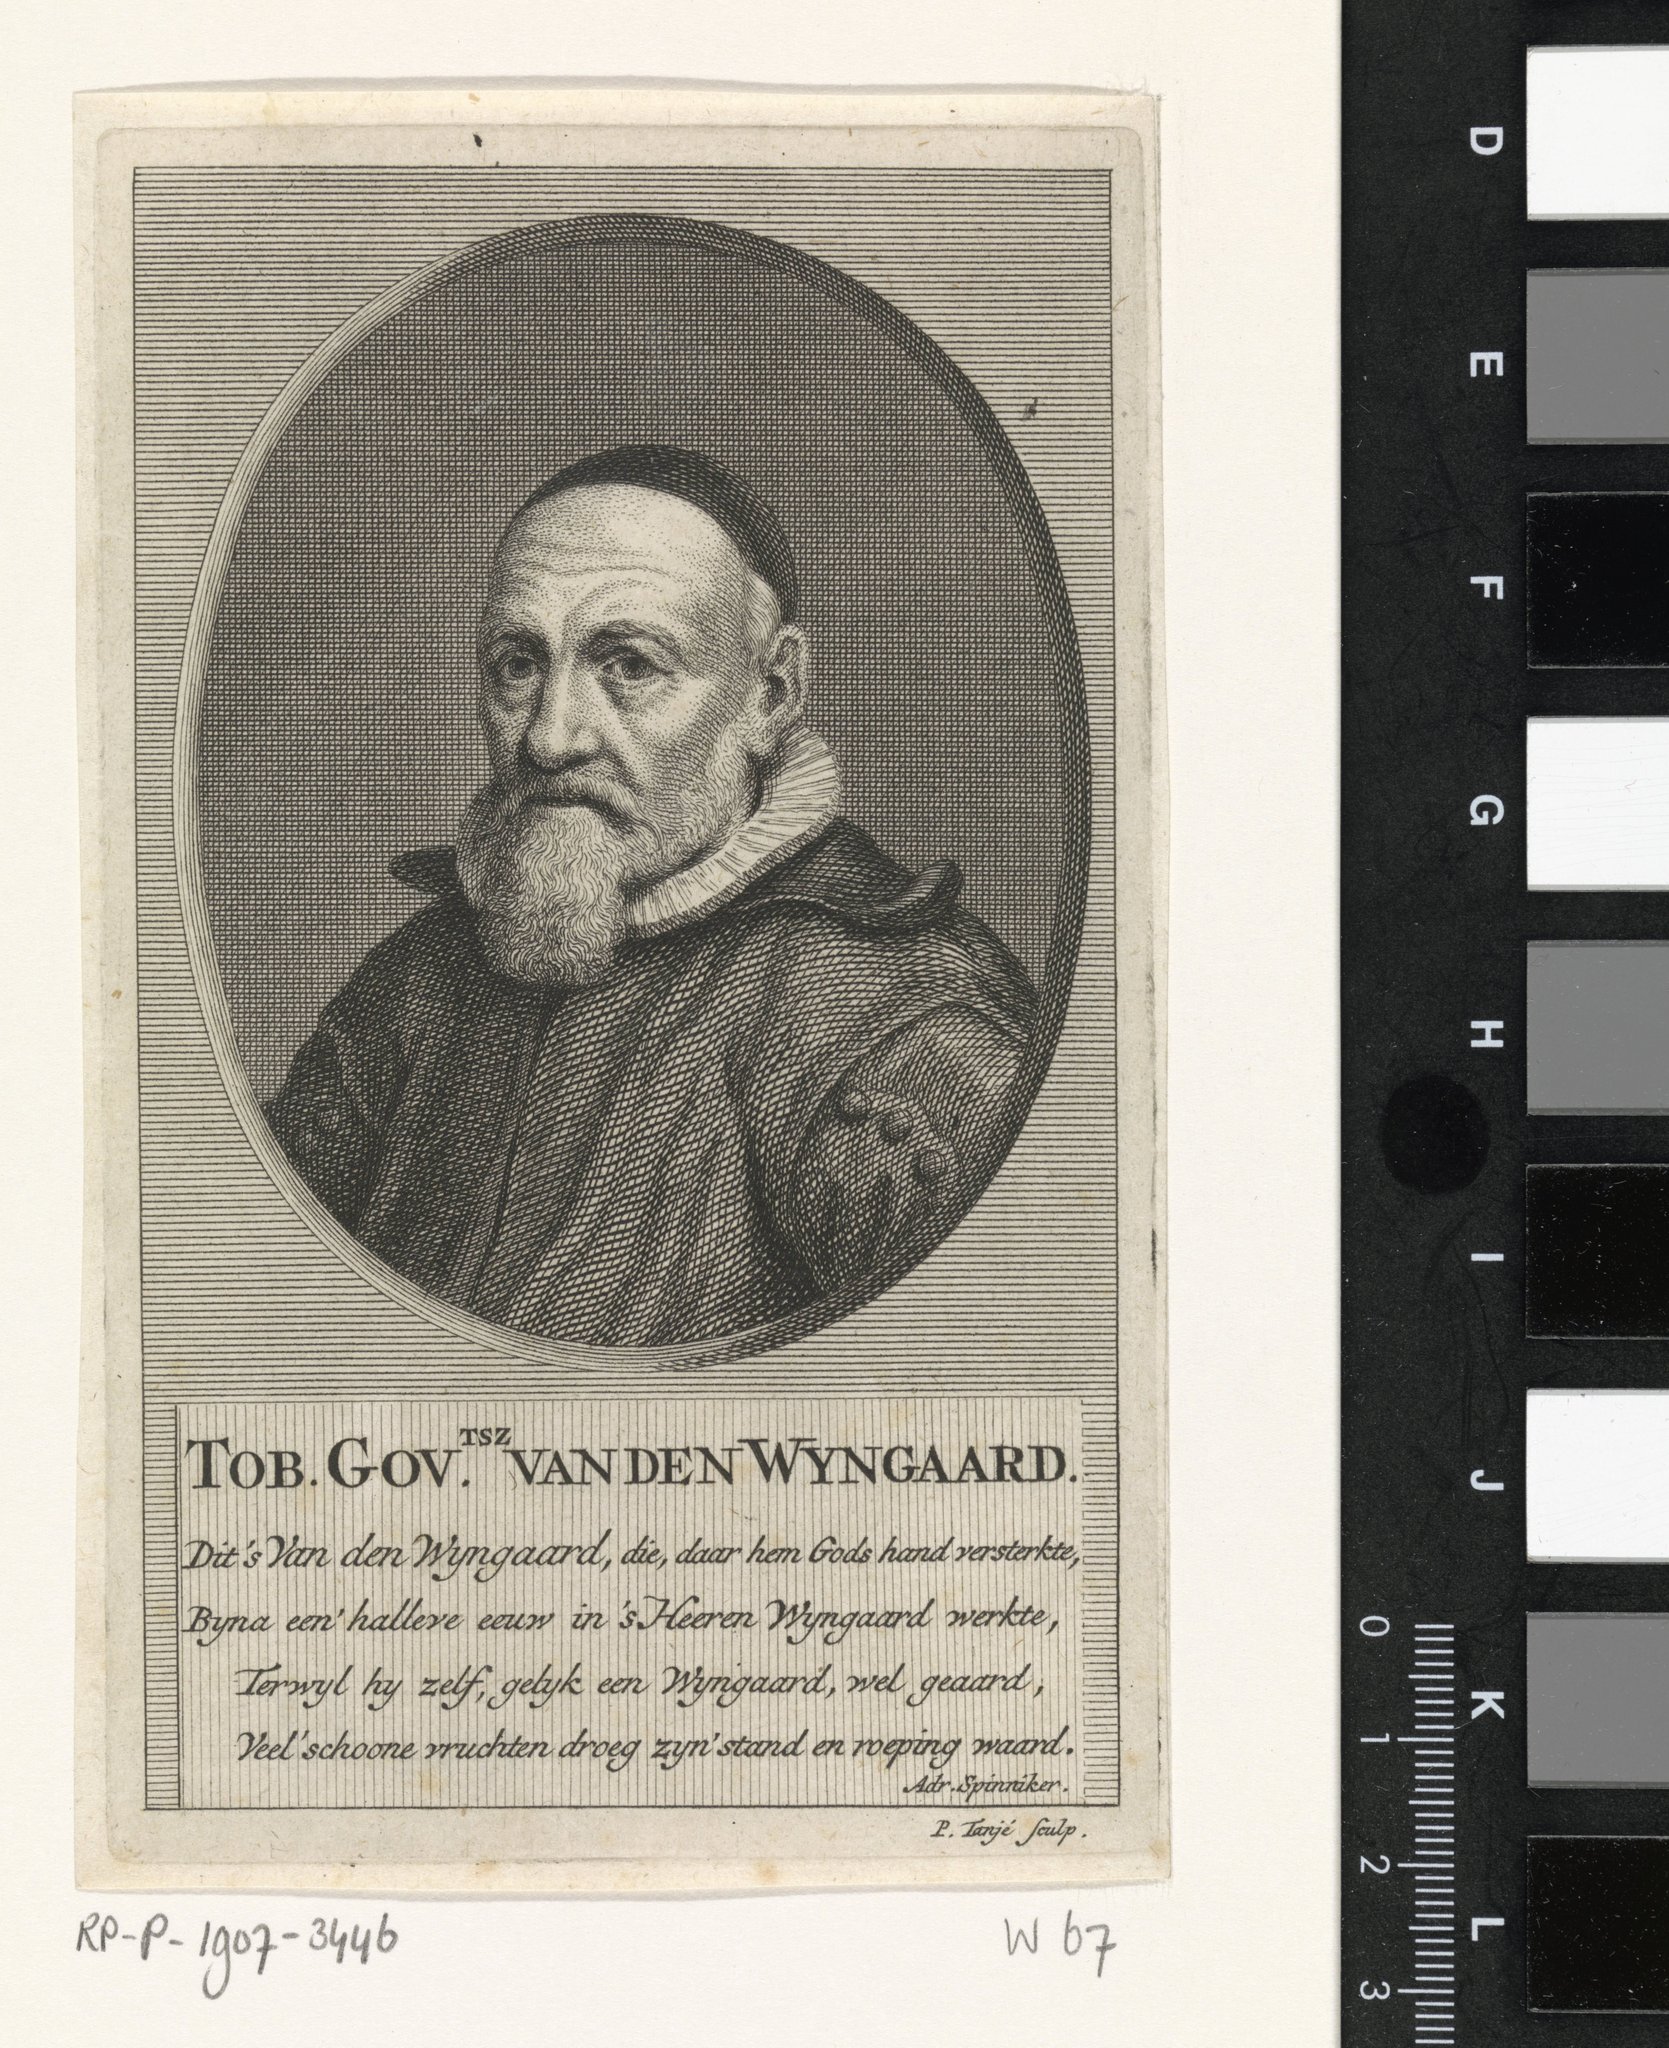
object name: print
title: Portret van Tobias Govertsz. van den Wyngaert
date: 1716-1761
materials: paper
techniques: engraving, etching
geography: amsterdam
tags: tobias govertsz. van den wyngaert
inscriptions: collector's mark: Lugt 2228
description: Tobias Govertsz. van den Wyngaert, predikant van de Vlaamse doopsgezinde gemeente te Amsterdam. Onder zijn portret een vierregelig vers in het Nederlands.